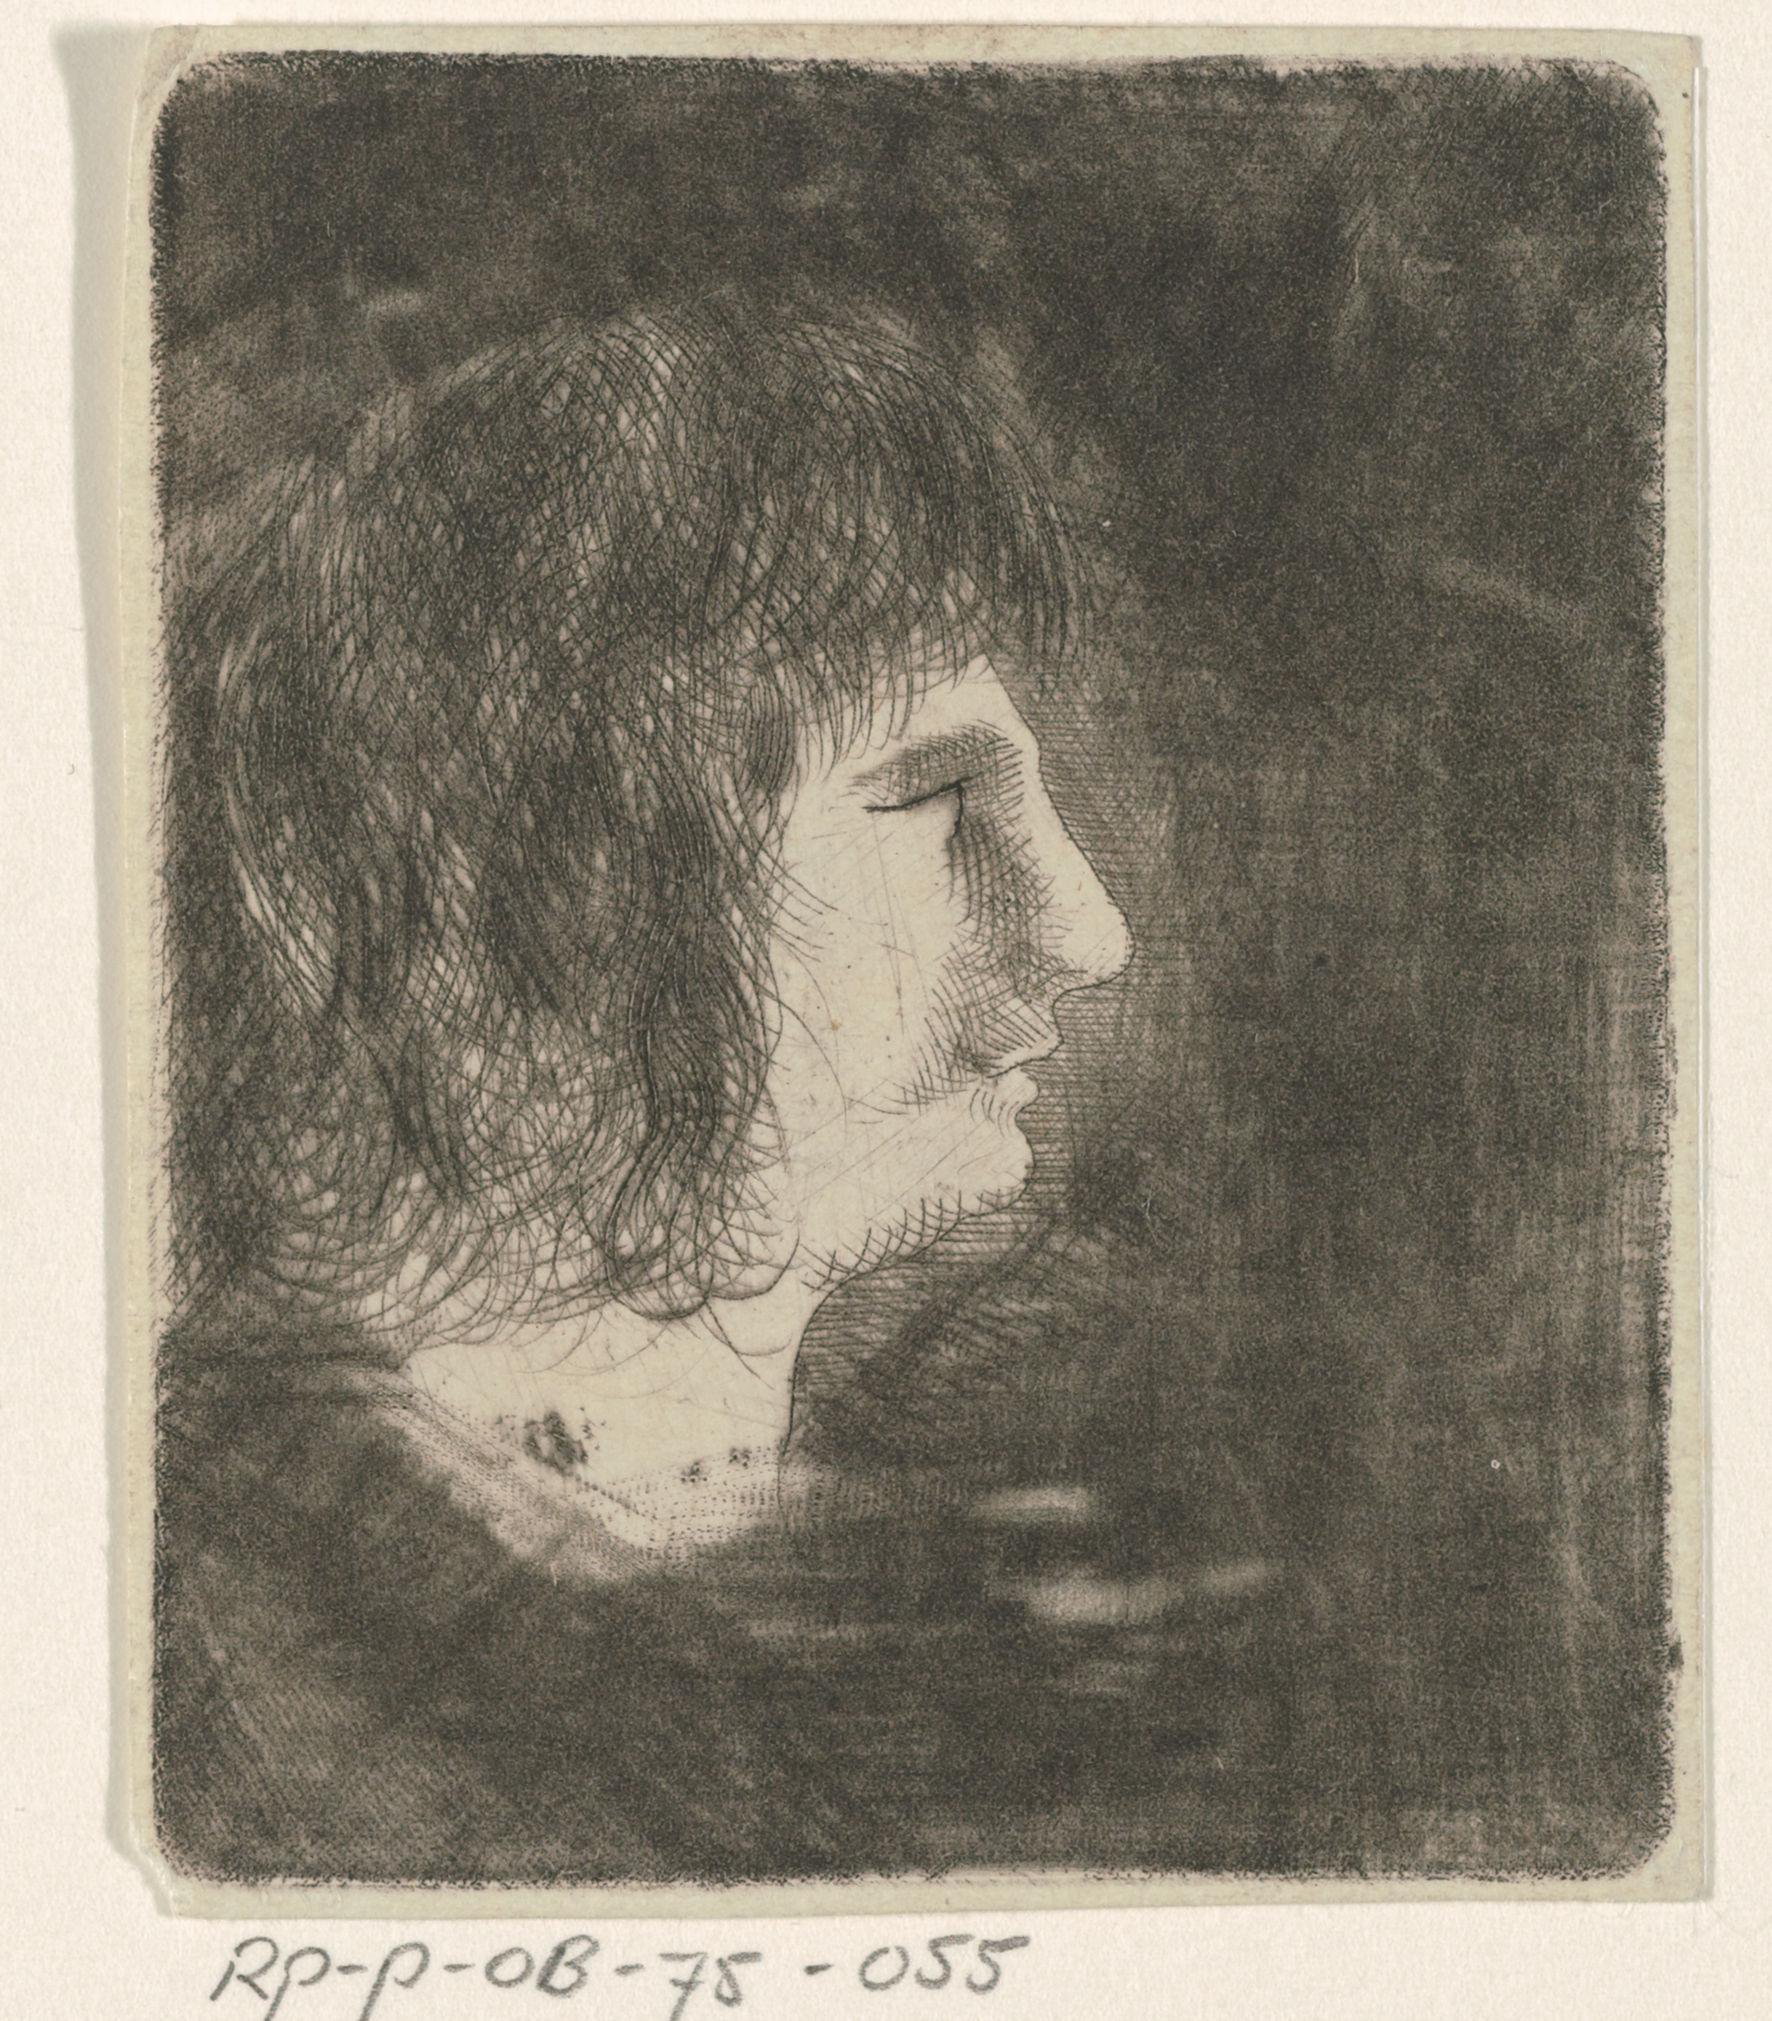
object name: print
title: Gezicht van een man in profiel naar rechts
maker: Anonymous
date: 1700-1900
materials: paper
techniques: drypoint, roulette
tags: head (human) (+ sideview, profile)